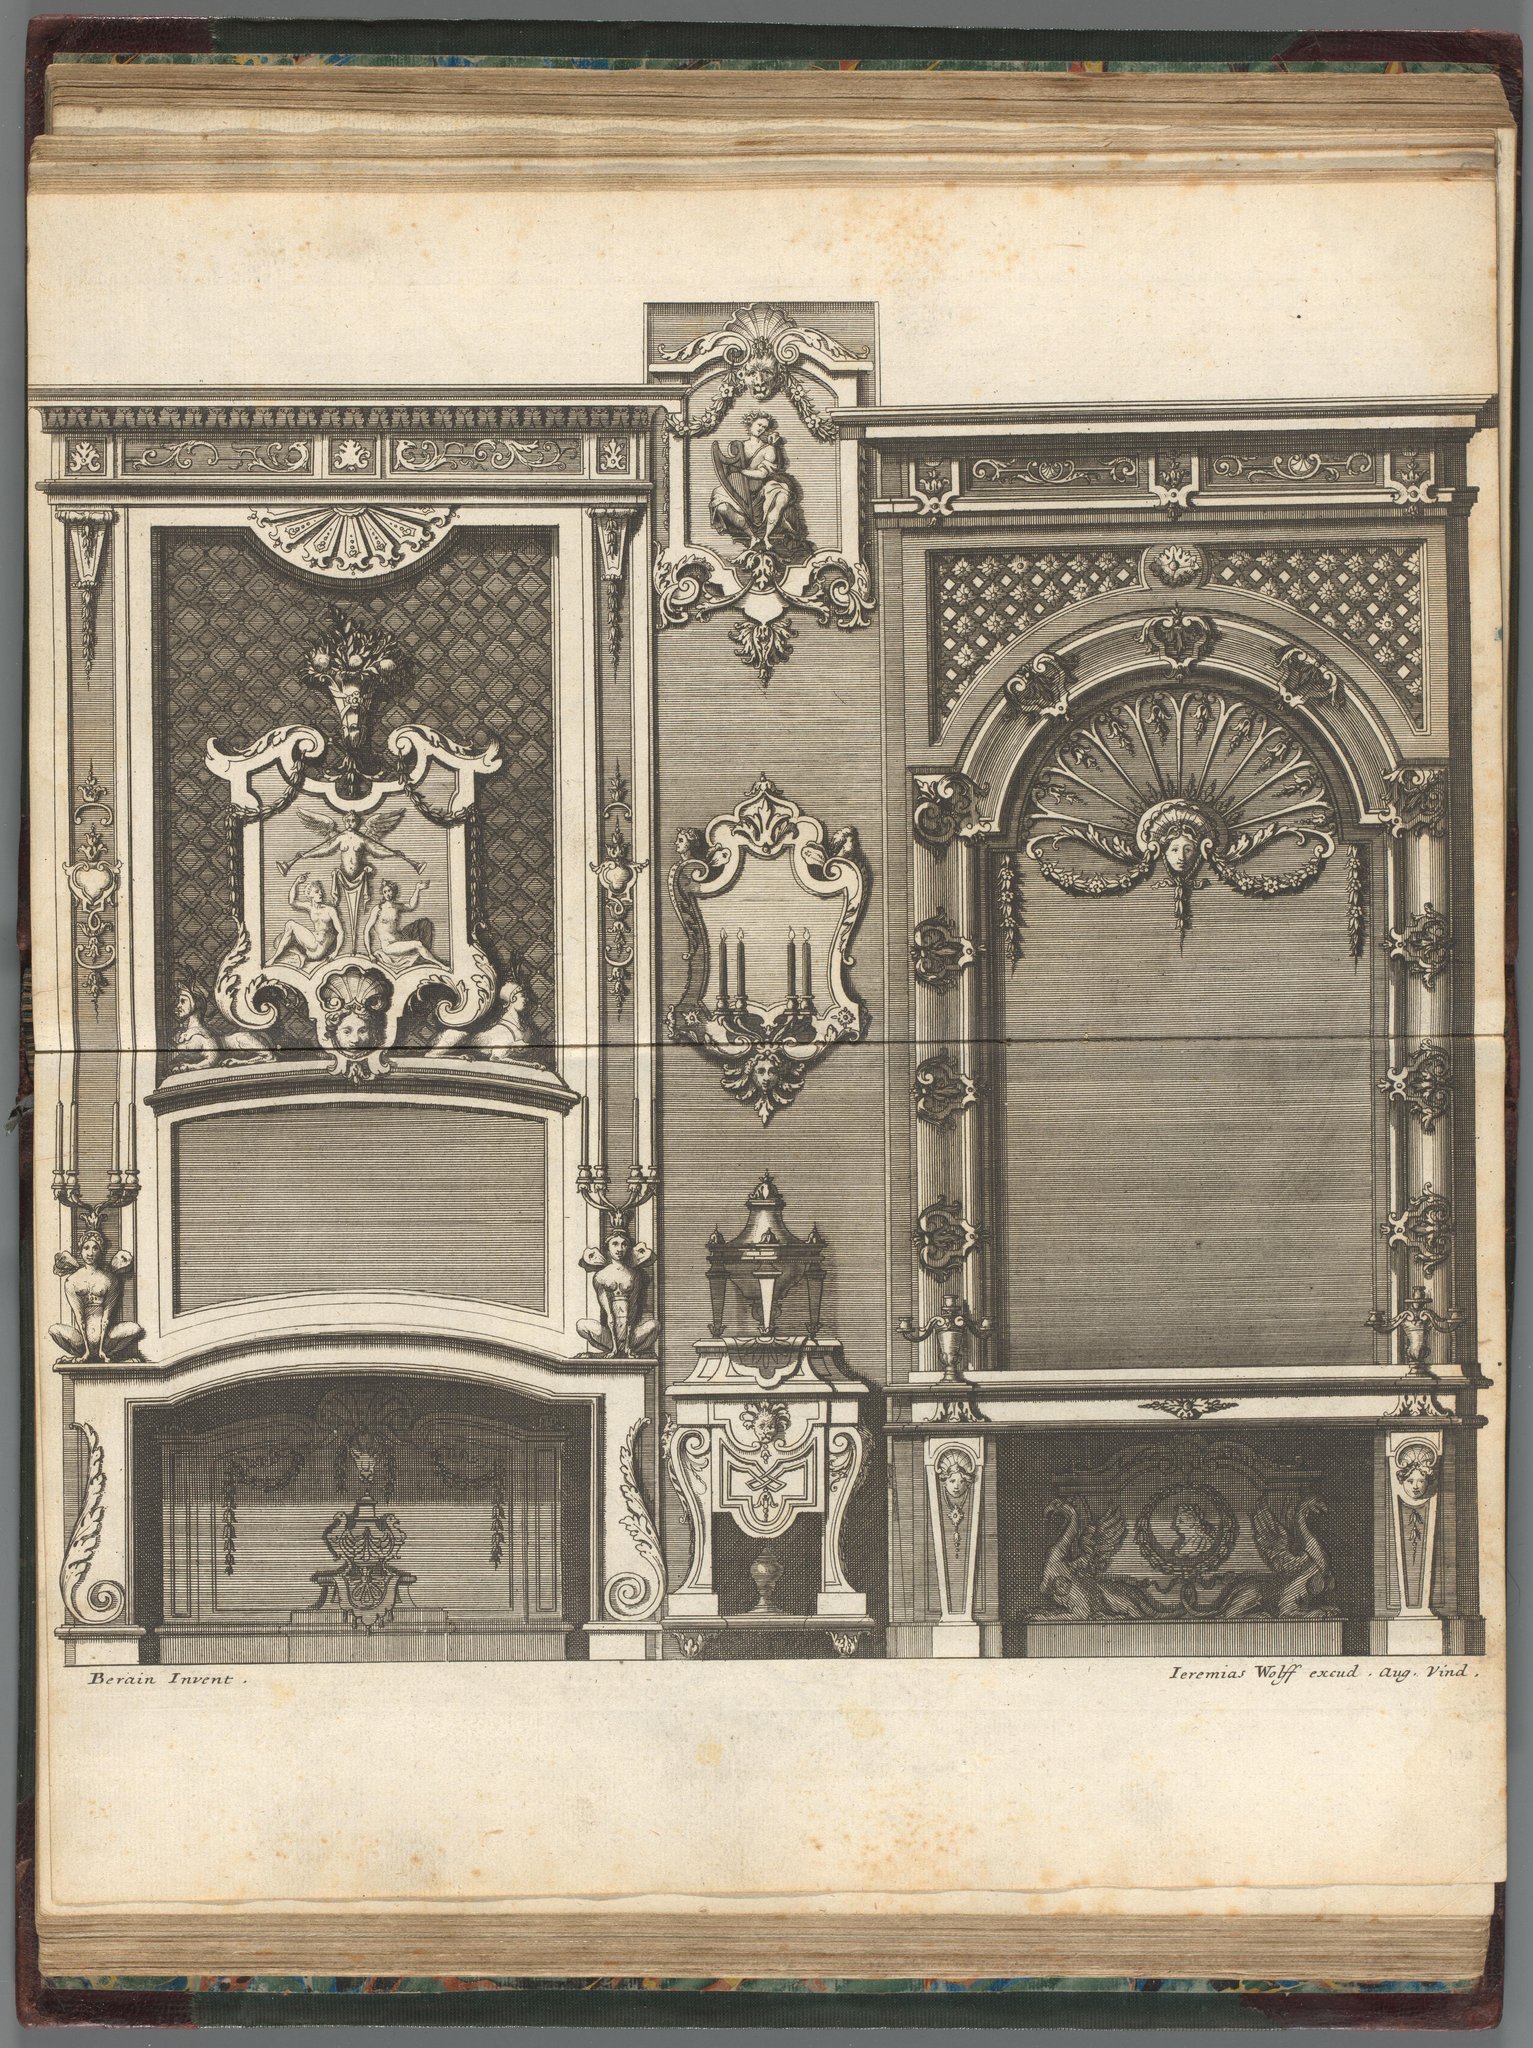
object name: album leaf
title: Haarden met herme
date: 1686-1724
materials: paper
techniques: etching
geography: augsburg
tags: griffin (lion/eagle); 'griffo' (ripa), ornaments ~ art, fire-screen, ornament ~ medallion, open hearth, fire-place, mask, mascaron ~ ornament, ornament ~ festoon, garland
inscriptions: signature: ‘Berain Invent’, signature: ‘Ieremias Wolff excud. Aug. Vind.’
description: Twee geornamenteerde haarden. Links met een vrouwelijke herme blazend op twee bazuinen en onderaan een haardplaat met ramskop. Rechts met een masker met guirlandes en onderaan een haardplaat met medaillon met een portret en profil en twee griffioenen. De haarden flankeren een paneel met bovenaan een figuur met een harp, in het midden een omlijste kandelaar en onderaan een tafel. Prent maakt deel uit van een album. Hoogstwaarschijnlijk gespiegelde kopie naar Frans origineel.